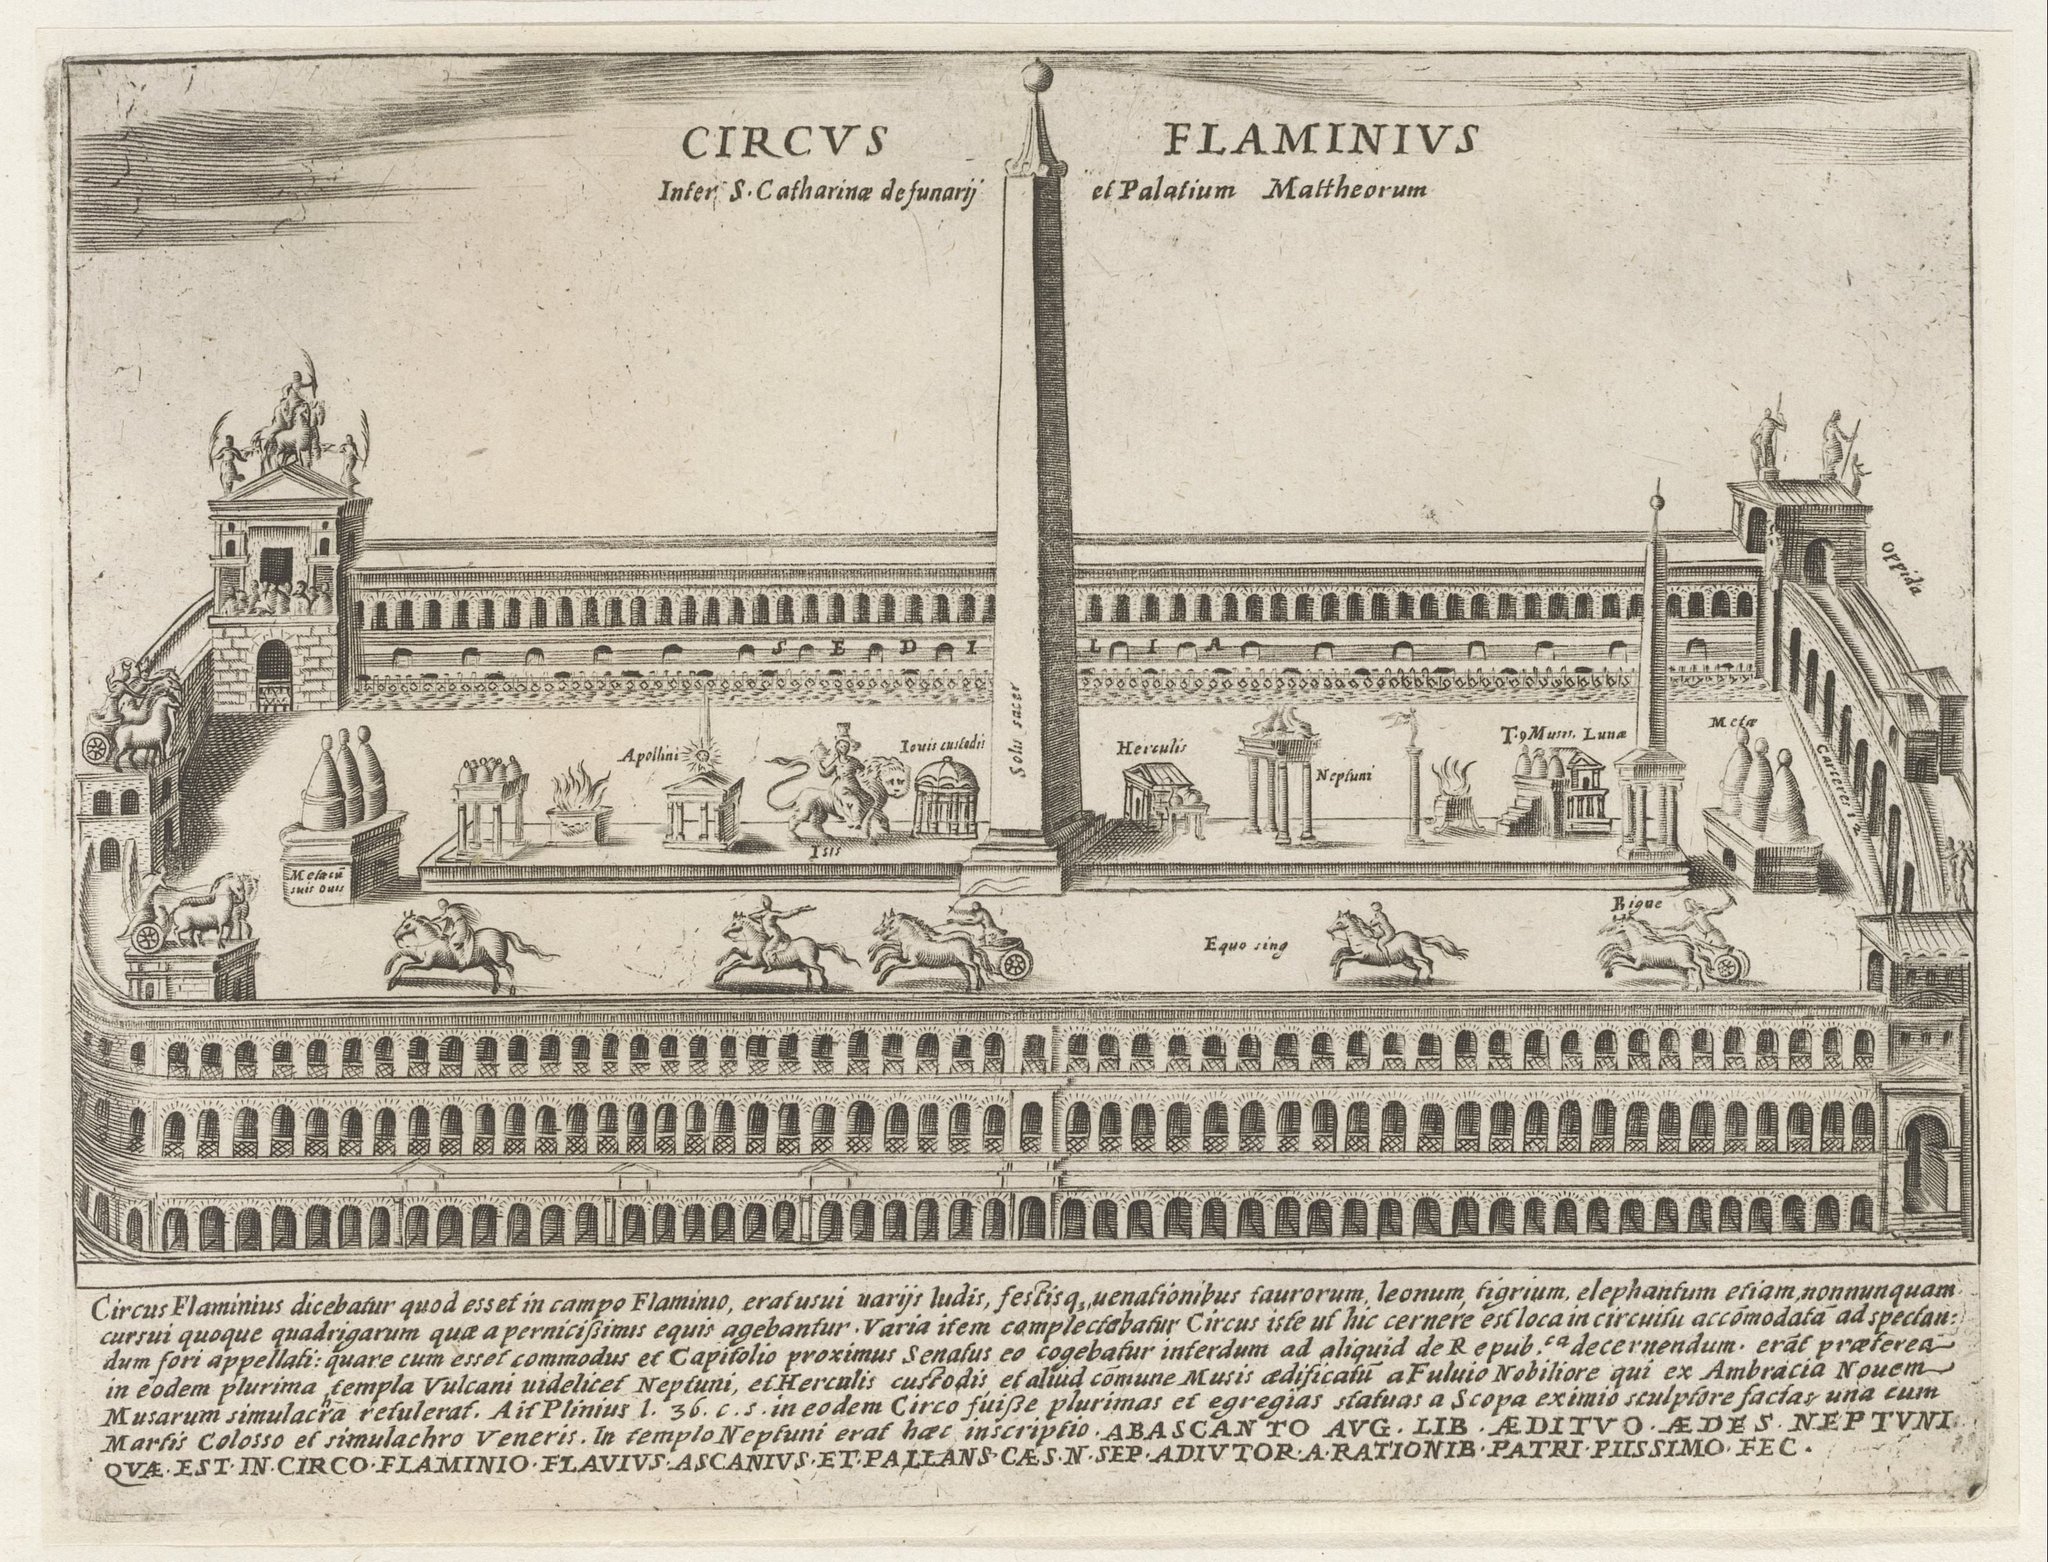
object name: print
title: Circus Flaminius te Rome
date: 1612-1628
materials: paper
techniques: etching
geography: rome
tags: race-track, representation of real building (either existing or having existed)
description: Deze prent maakt deel uit van een set van 158 prenten (+ titelprenten), die verscheen in vier delen. In 1612 verschenen delen één en twee. In 1615 verscheen het derde deel en in 1628 verscheen deel vier. In 1637 publiceerde Vitale Mascardi de eerste heruitgave van de gehele set met nummering.